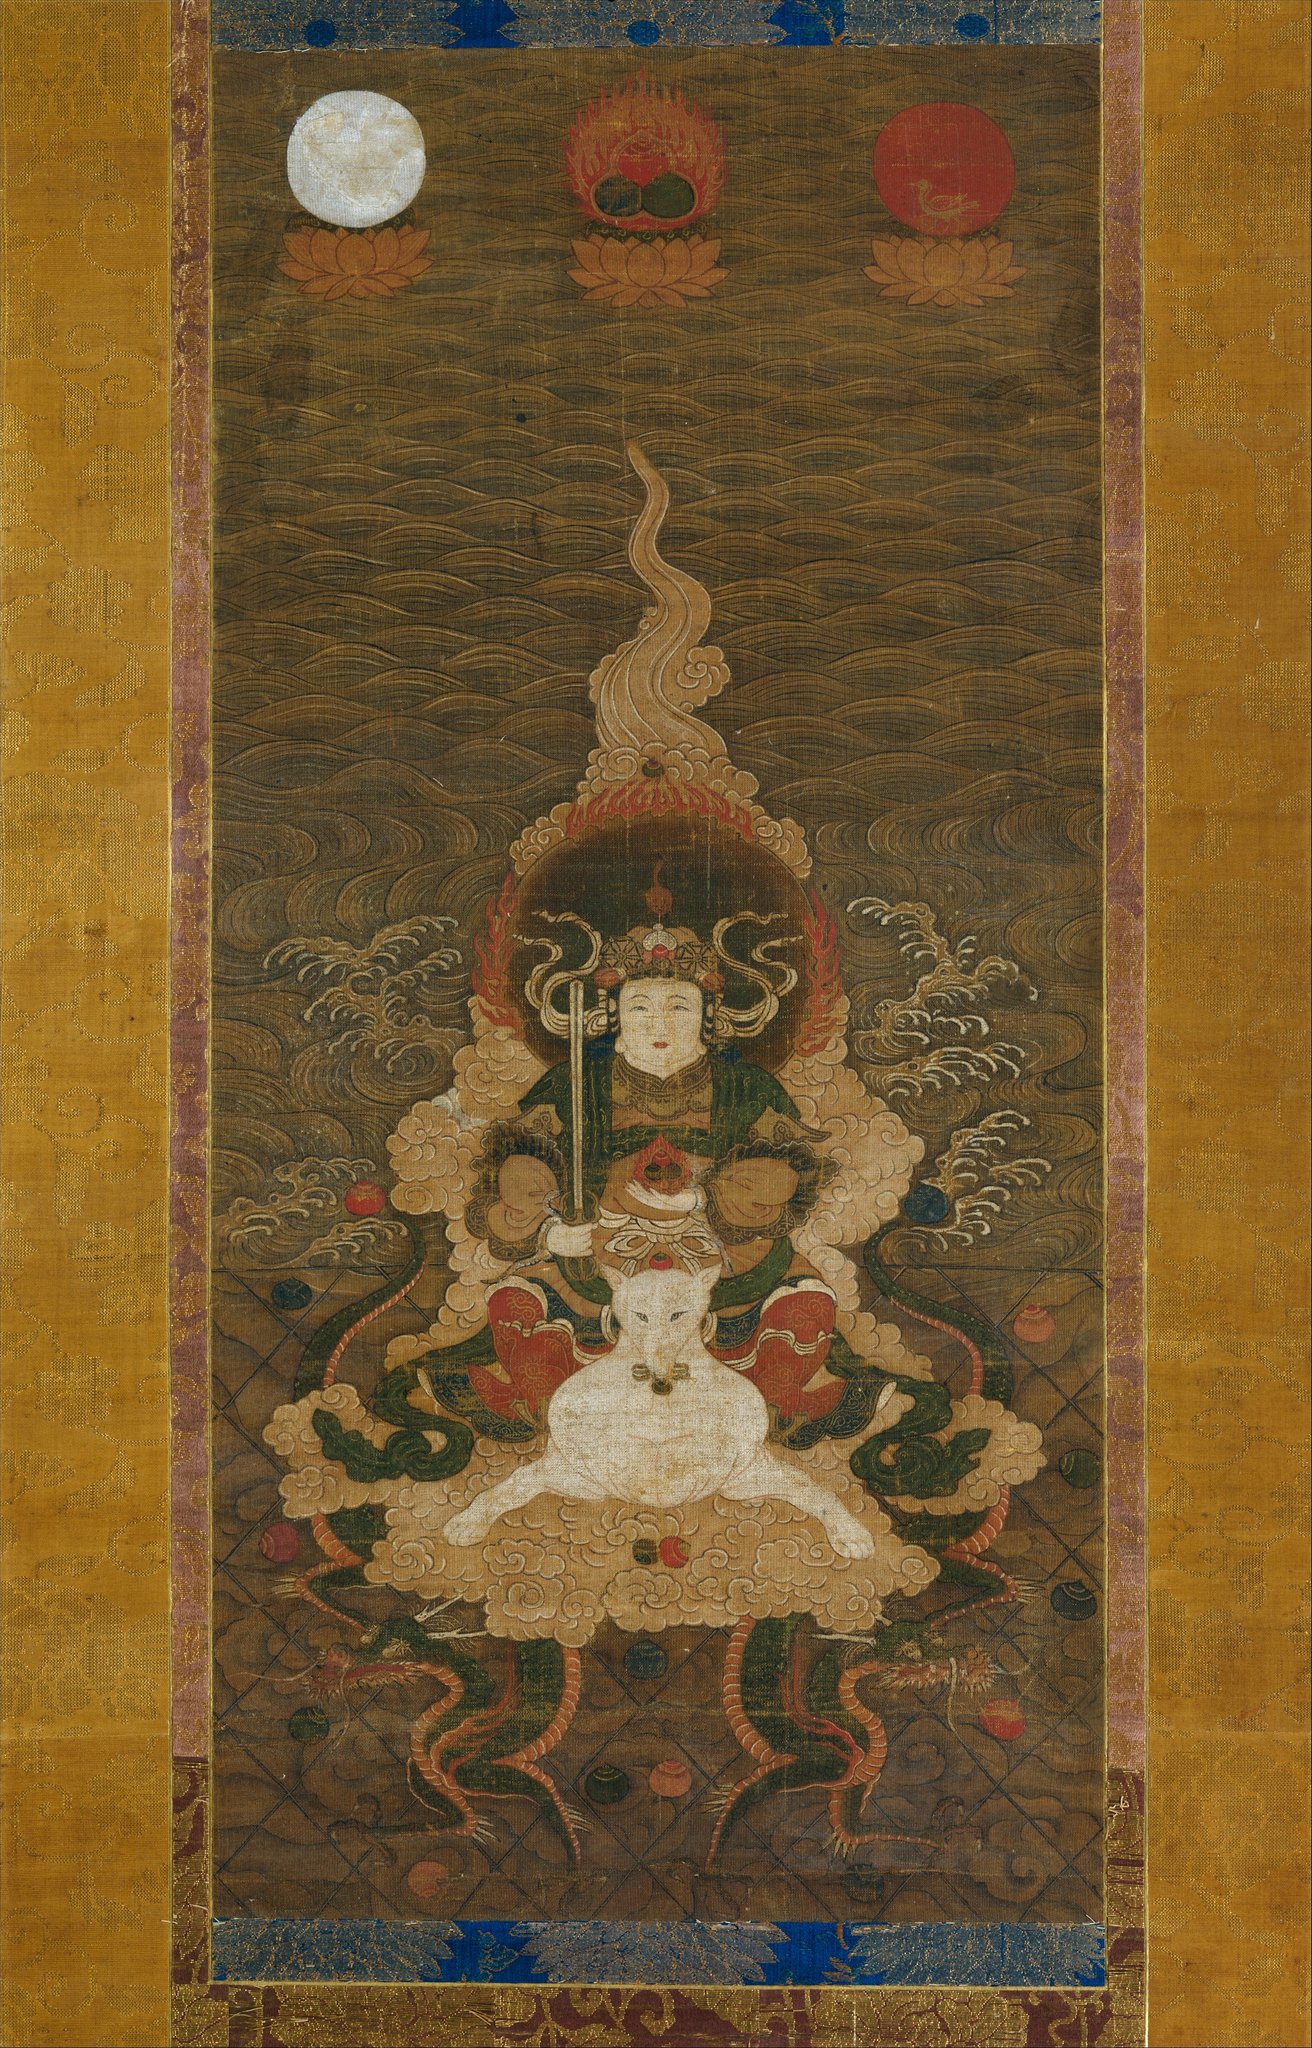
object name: hanging scroll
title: Dakini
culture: japanese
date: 1301-1400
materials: gold, hemp, ink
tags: swords,dragons,foxes,deities